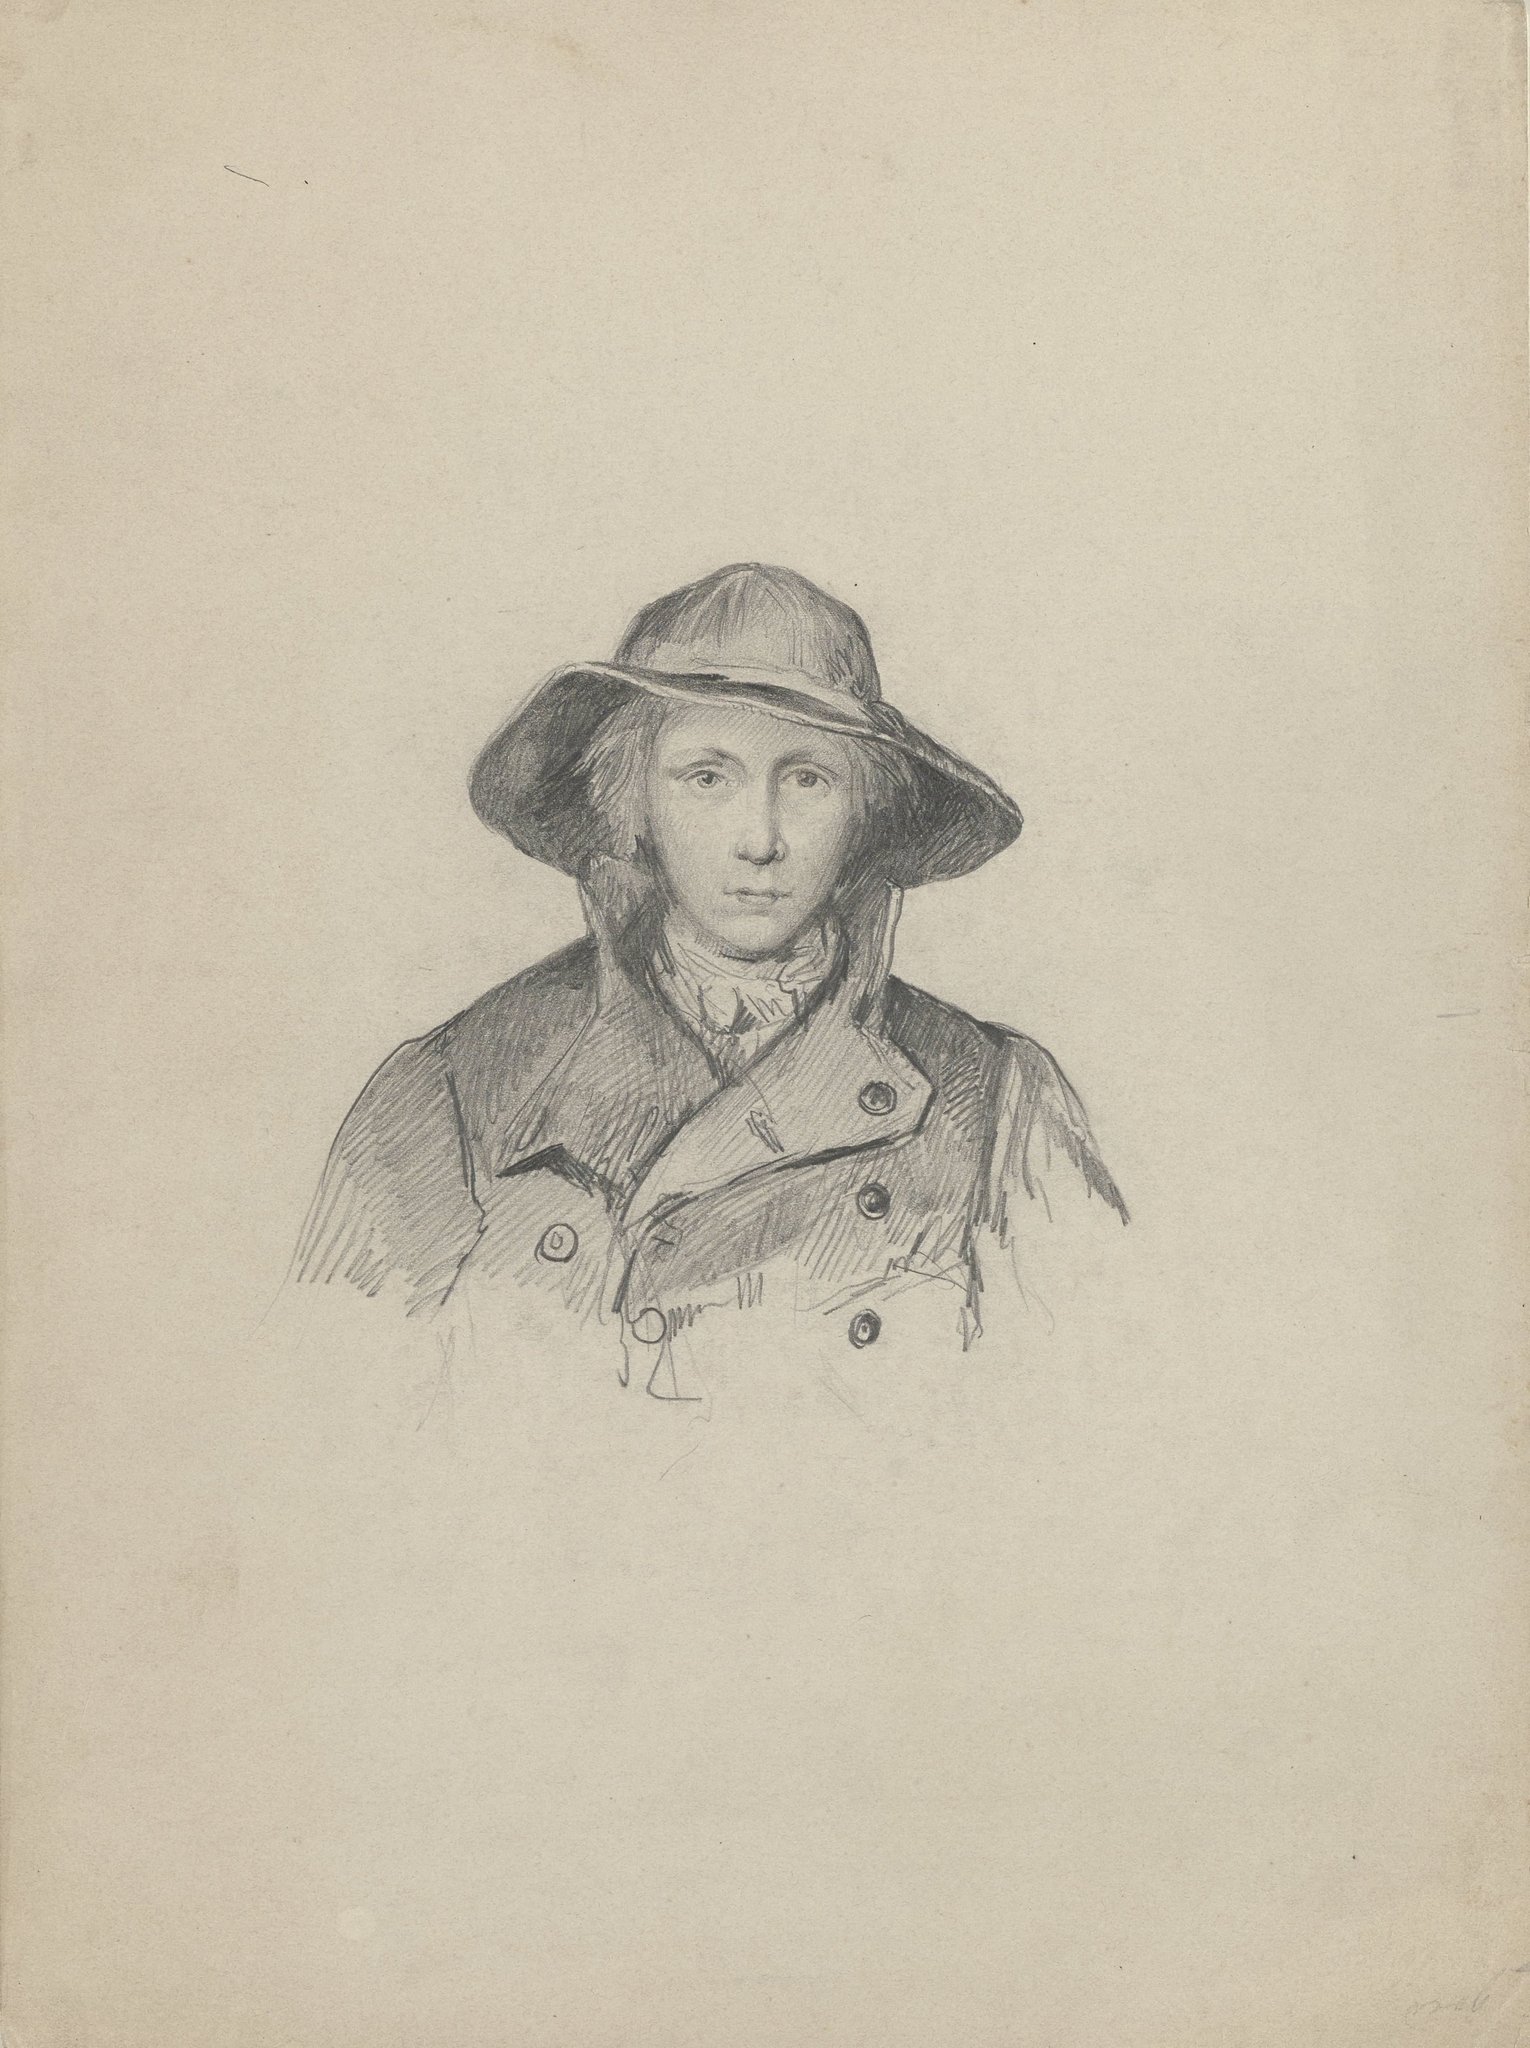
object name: drawing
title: Portret van een zoon van Klaas Bording, 1849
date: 1849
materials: paper, pencil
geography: netherlands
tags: saving a person from drowning, drift ice, zuiderzee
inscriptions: collector's mark: Lugt 2228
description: Portret van één van de twee zoons van Klaas Bording. Klaas Bording dreef met zijn twee zoons uit Durgerdam tussen 13-27 januari 1849 veertien dagen op een ijsschots op de Zuiderzee. Zie ook de andere twee portretten.